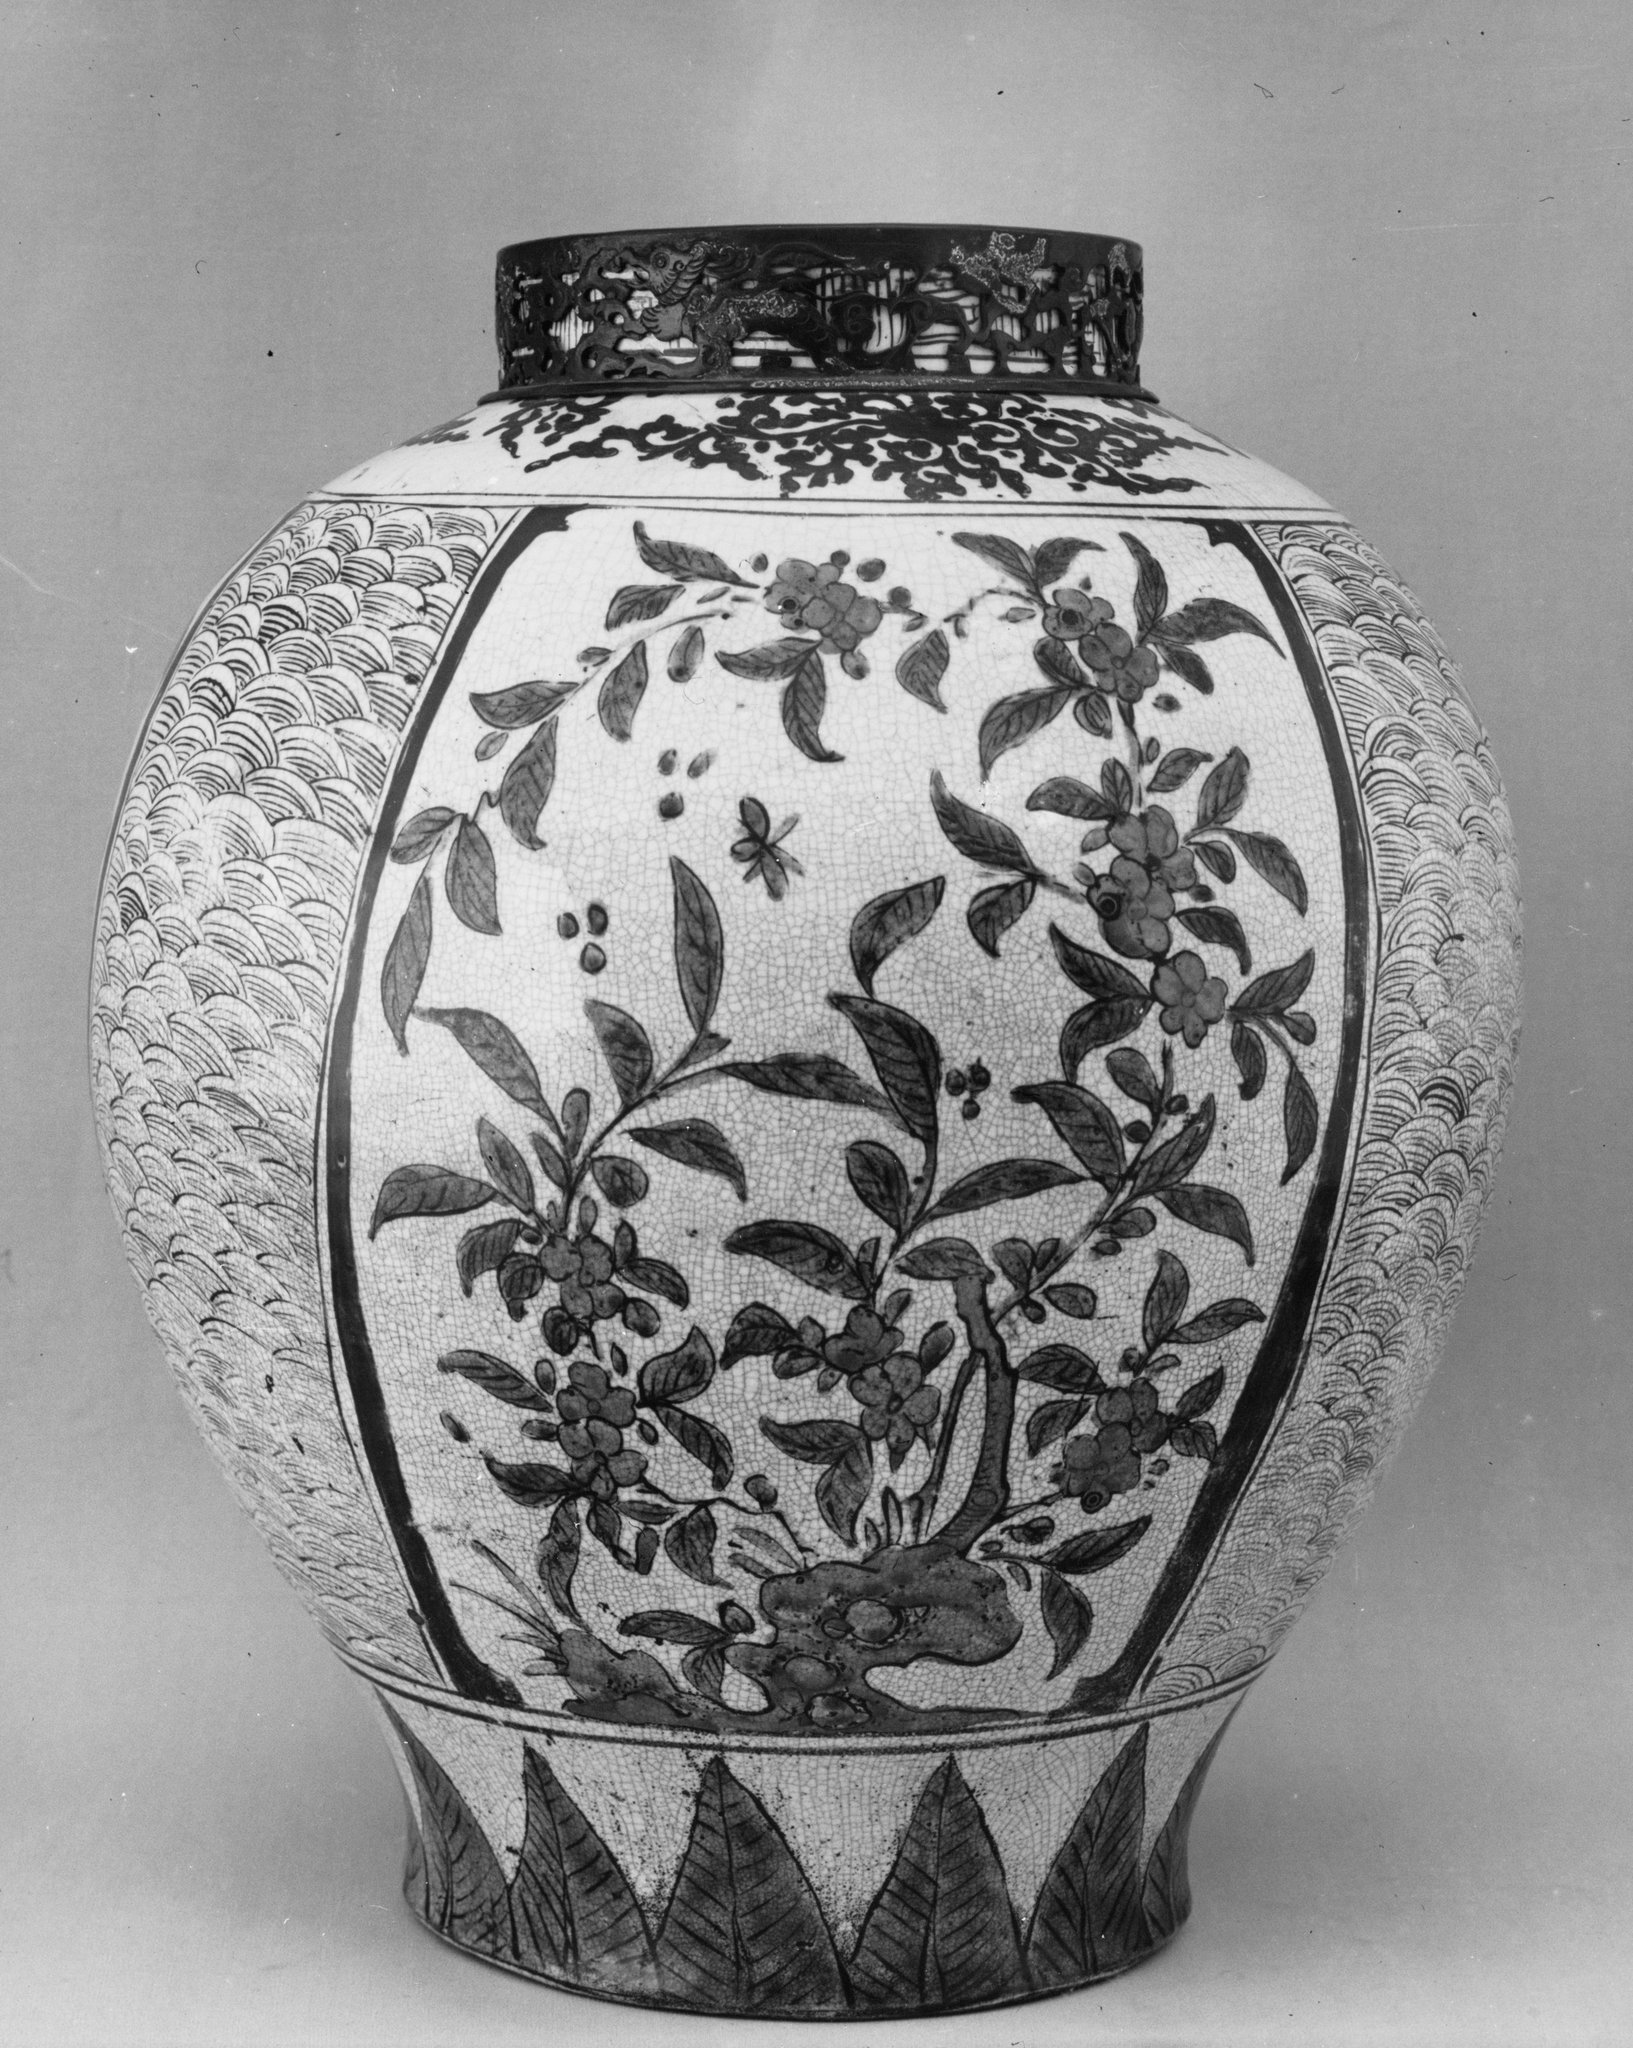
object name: jar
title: Large Jar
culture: japanese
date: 1670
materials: clay, enamel, glaze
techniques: polychrome